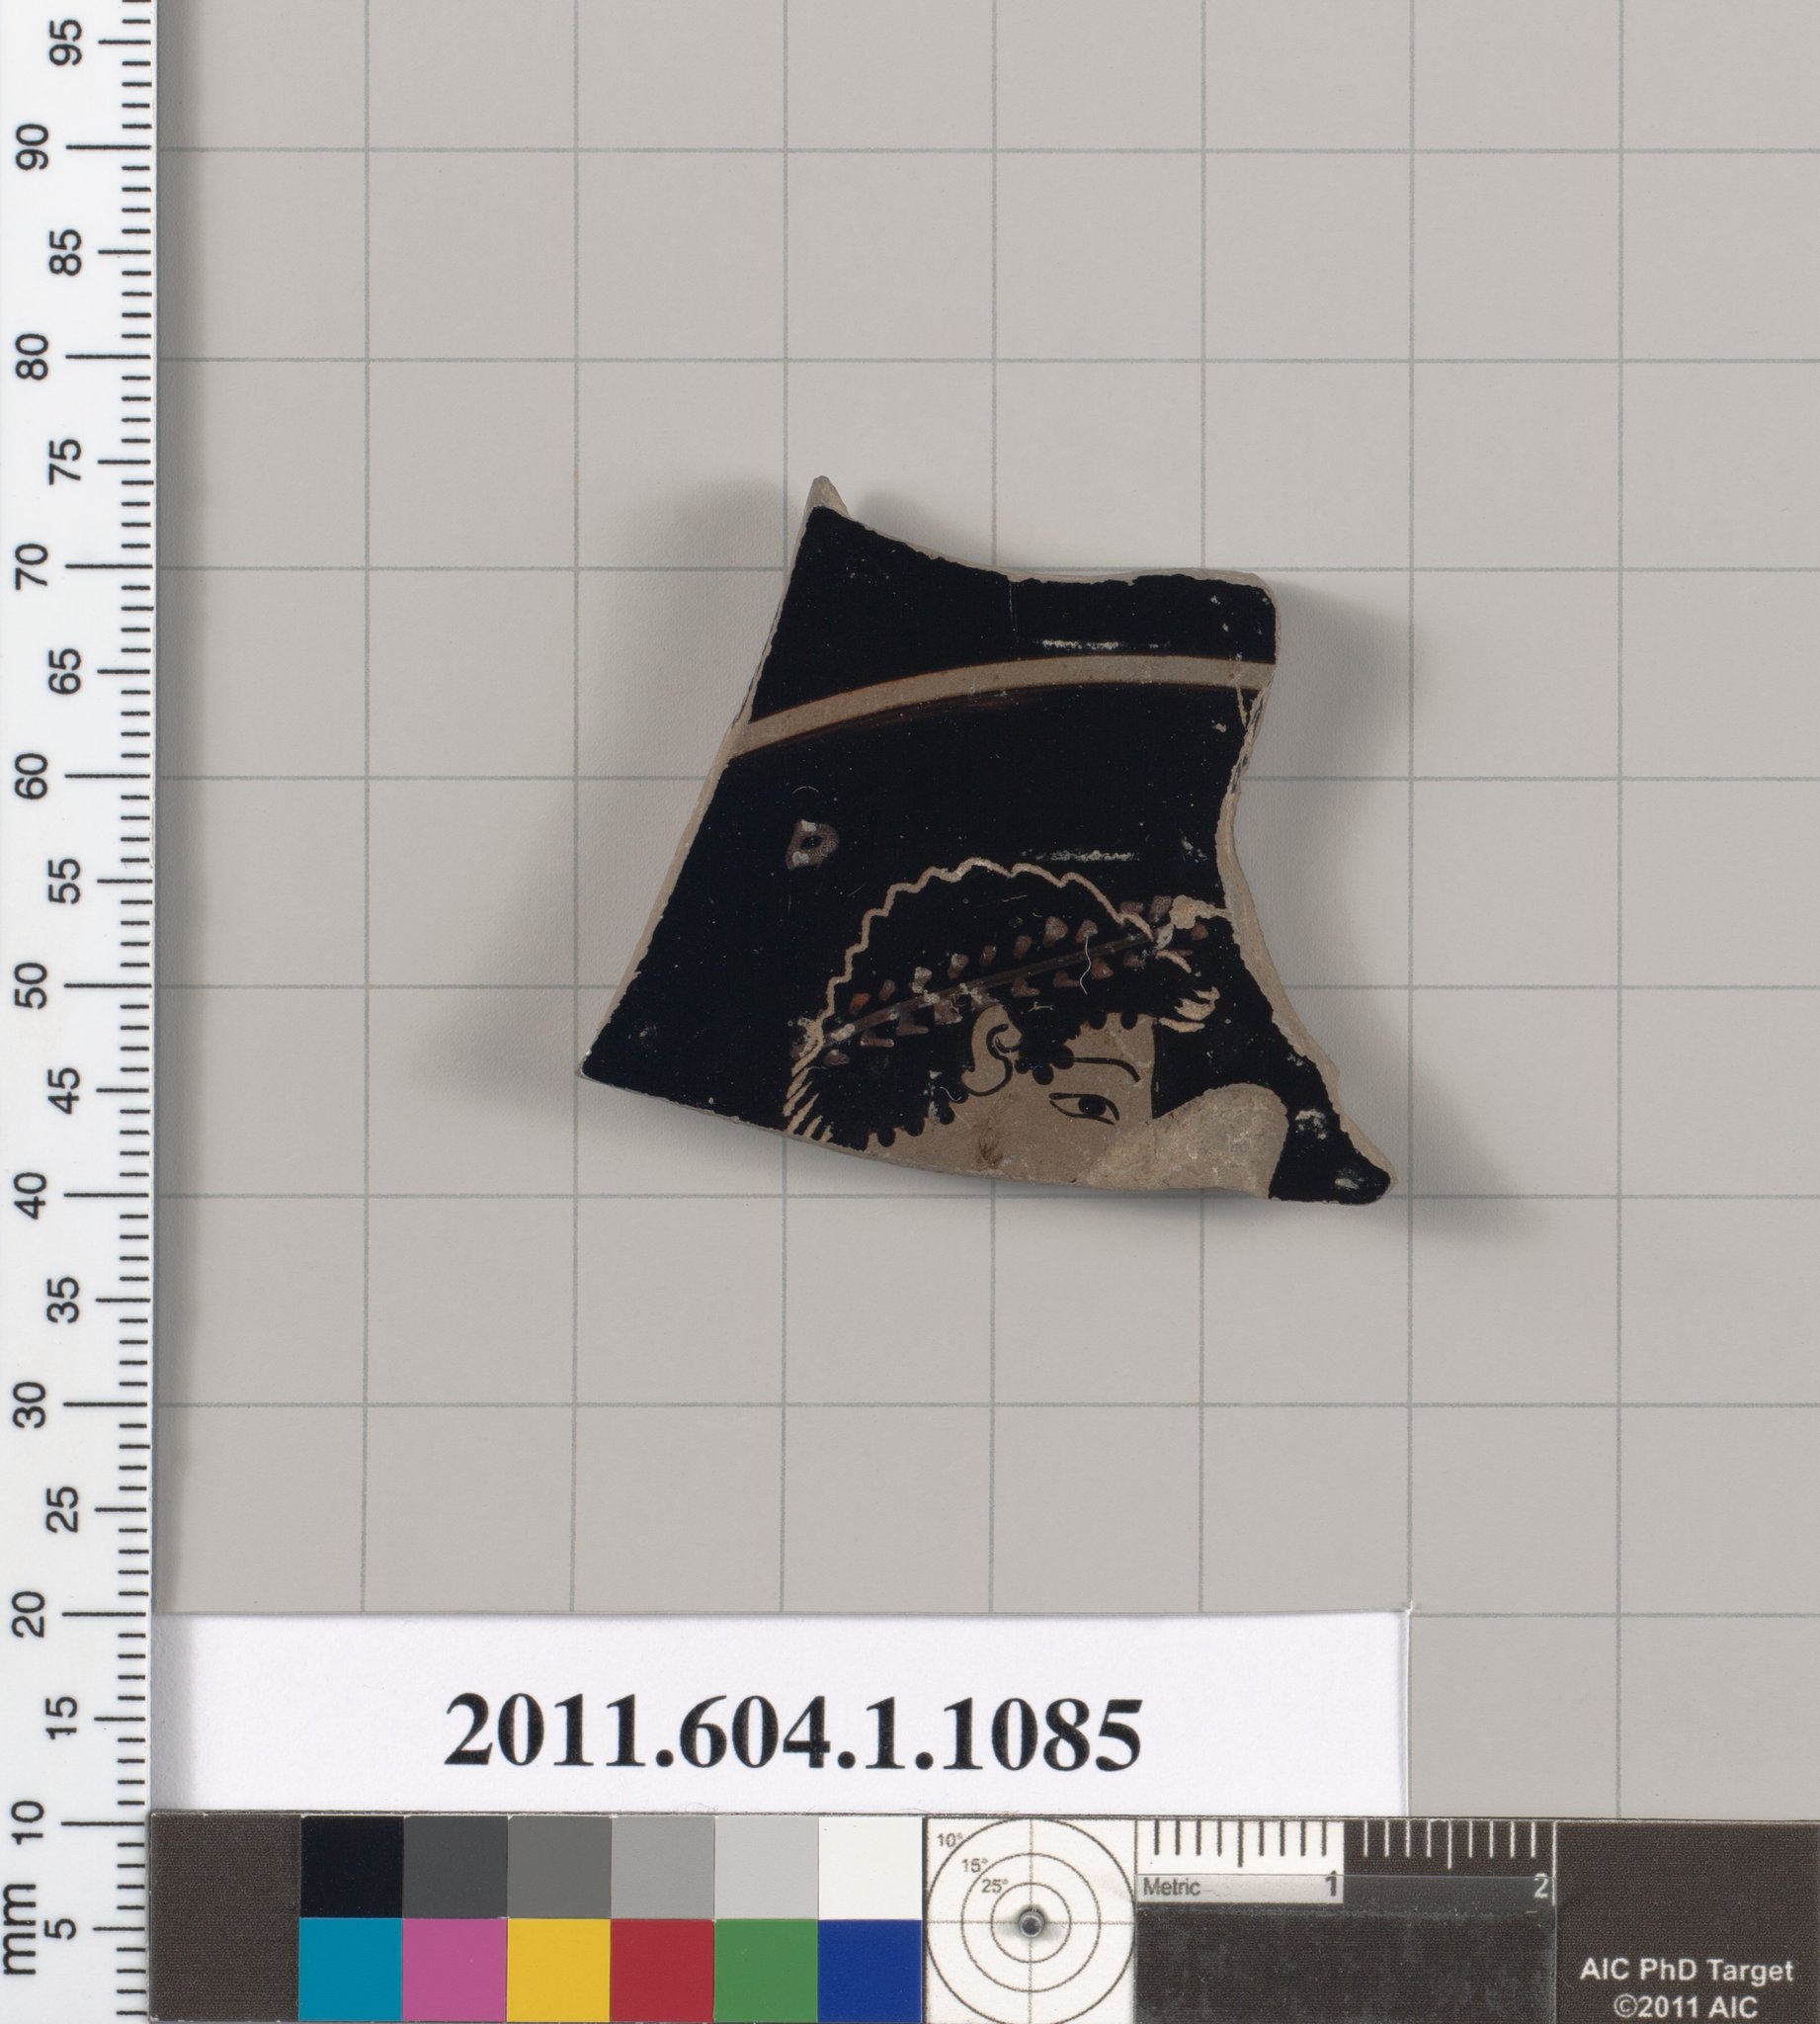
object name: kylix fragment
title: Terracotta fragment of a kylix (drinking cup)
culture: greek, attic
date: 510-490 BCE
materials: terracotta